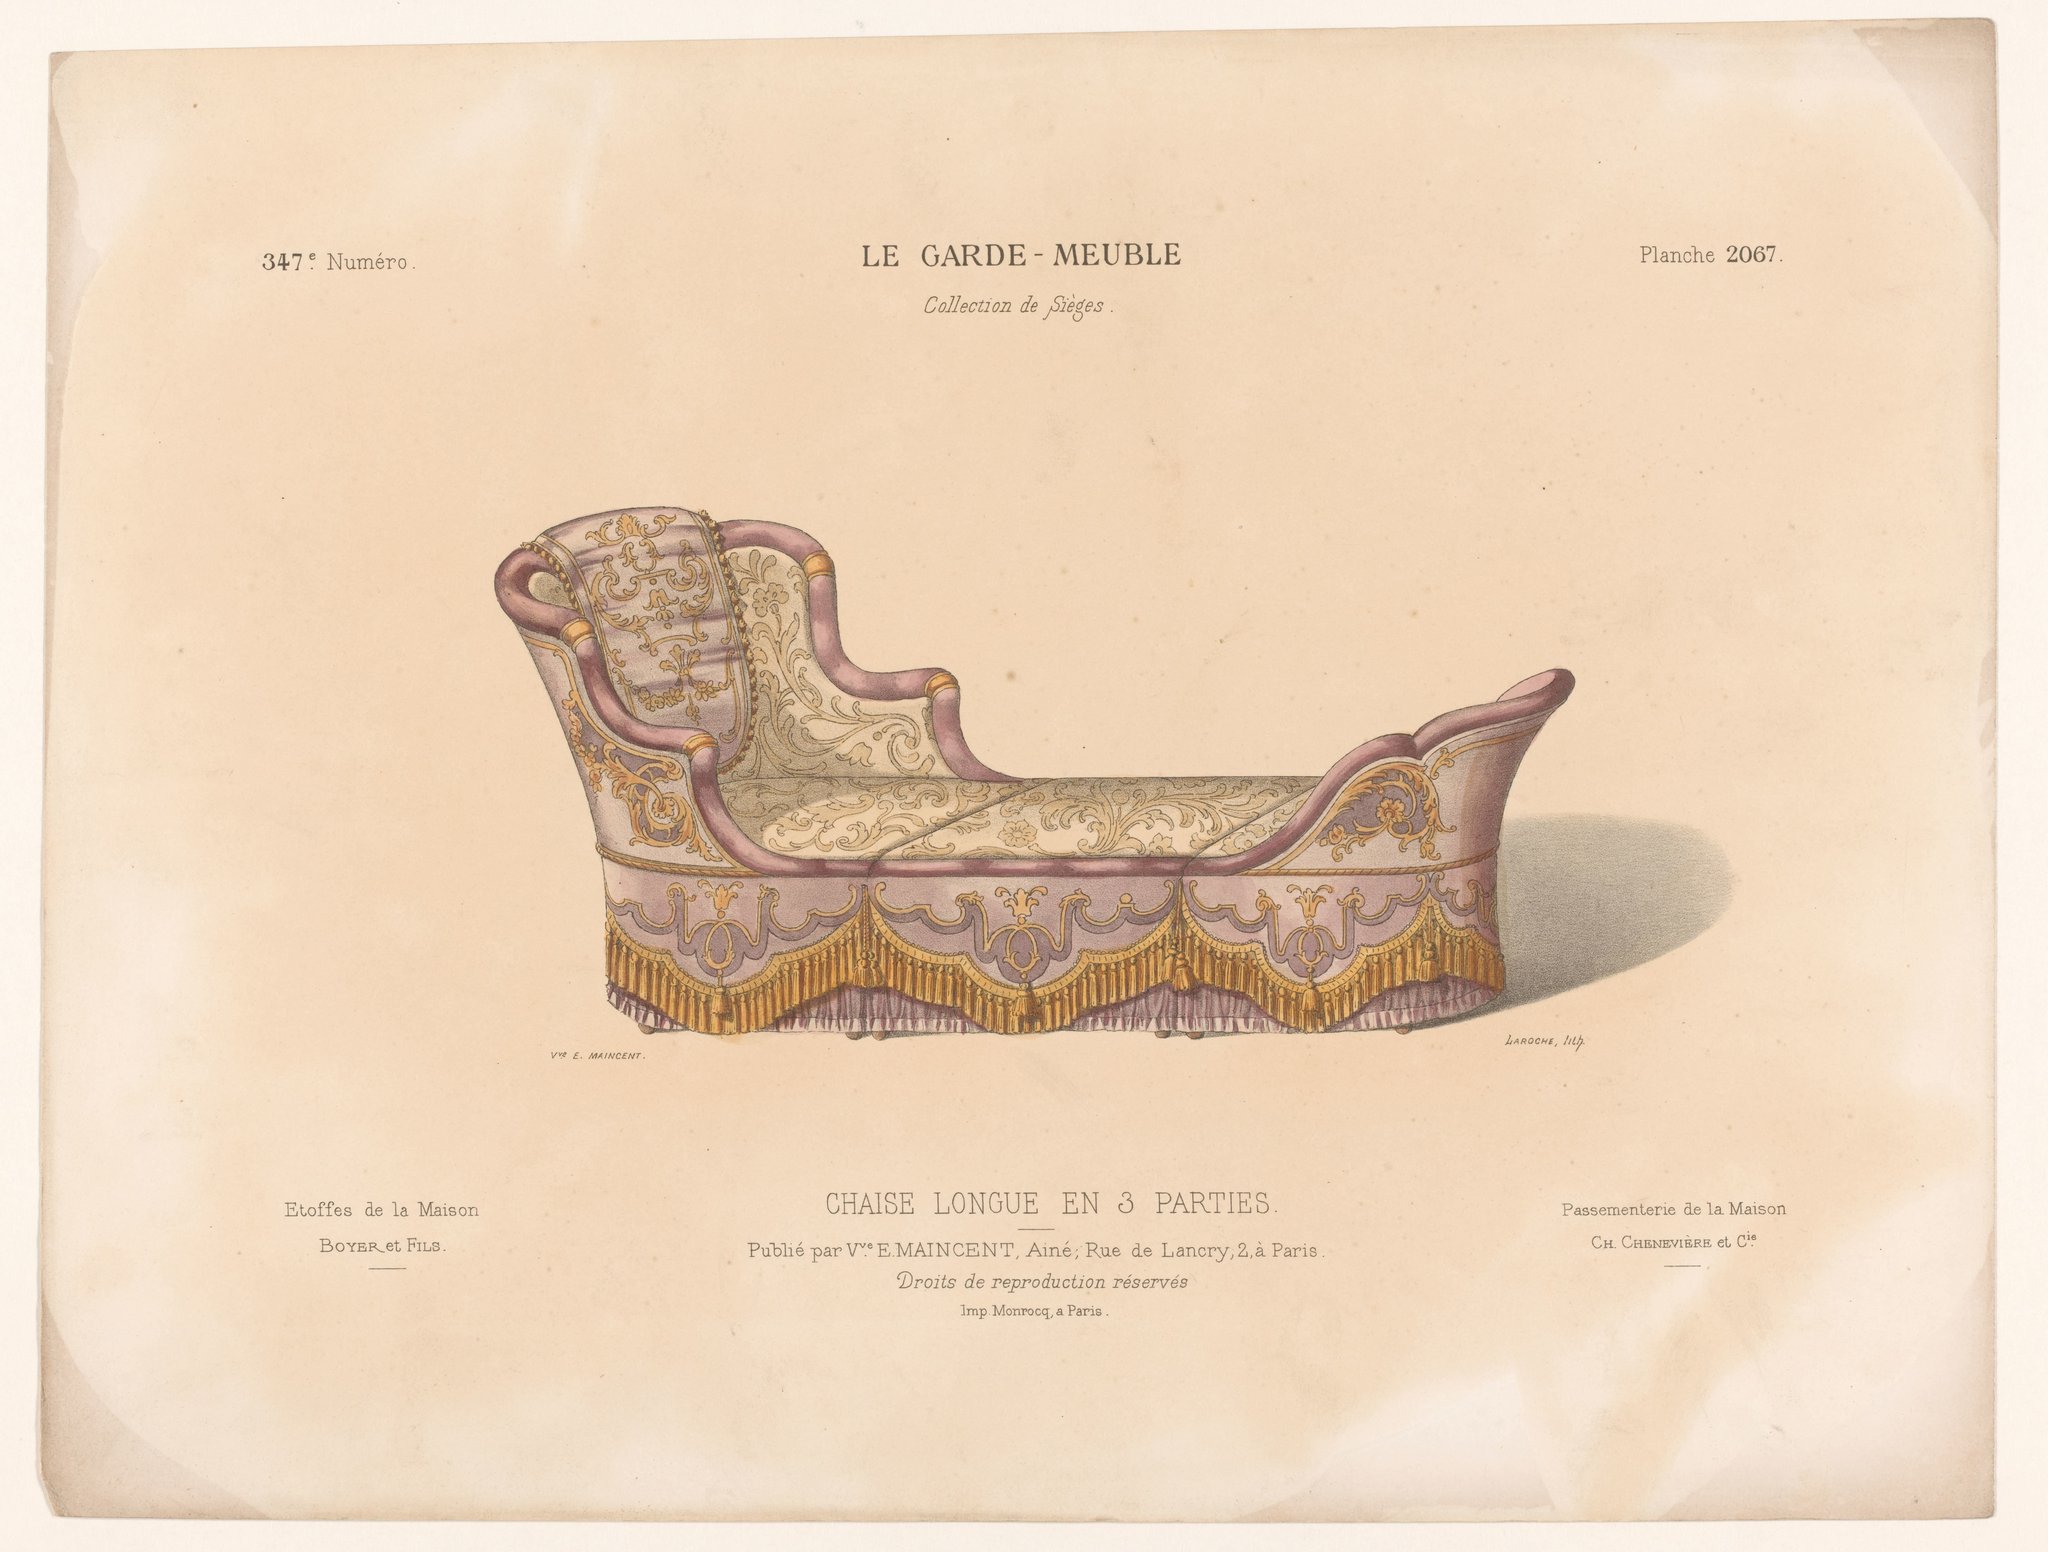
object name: print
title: Le garde-meuble / Collection de Sièges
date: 1895-1935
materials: paper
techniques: hand coloring, lithograph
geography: paris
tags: seating furniture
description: Ieder Livraison in de serie Le Garde-Meuble bevat negen platen: drie 'sièges' (zitmeubels), drie 'meubles' (diverse meubels zoals tafels en kasten) en drie 'tentures' (gordijnen en draperieën).